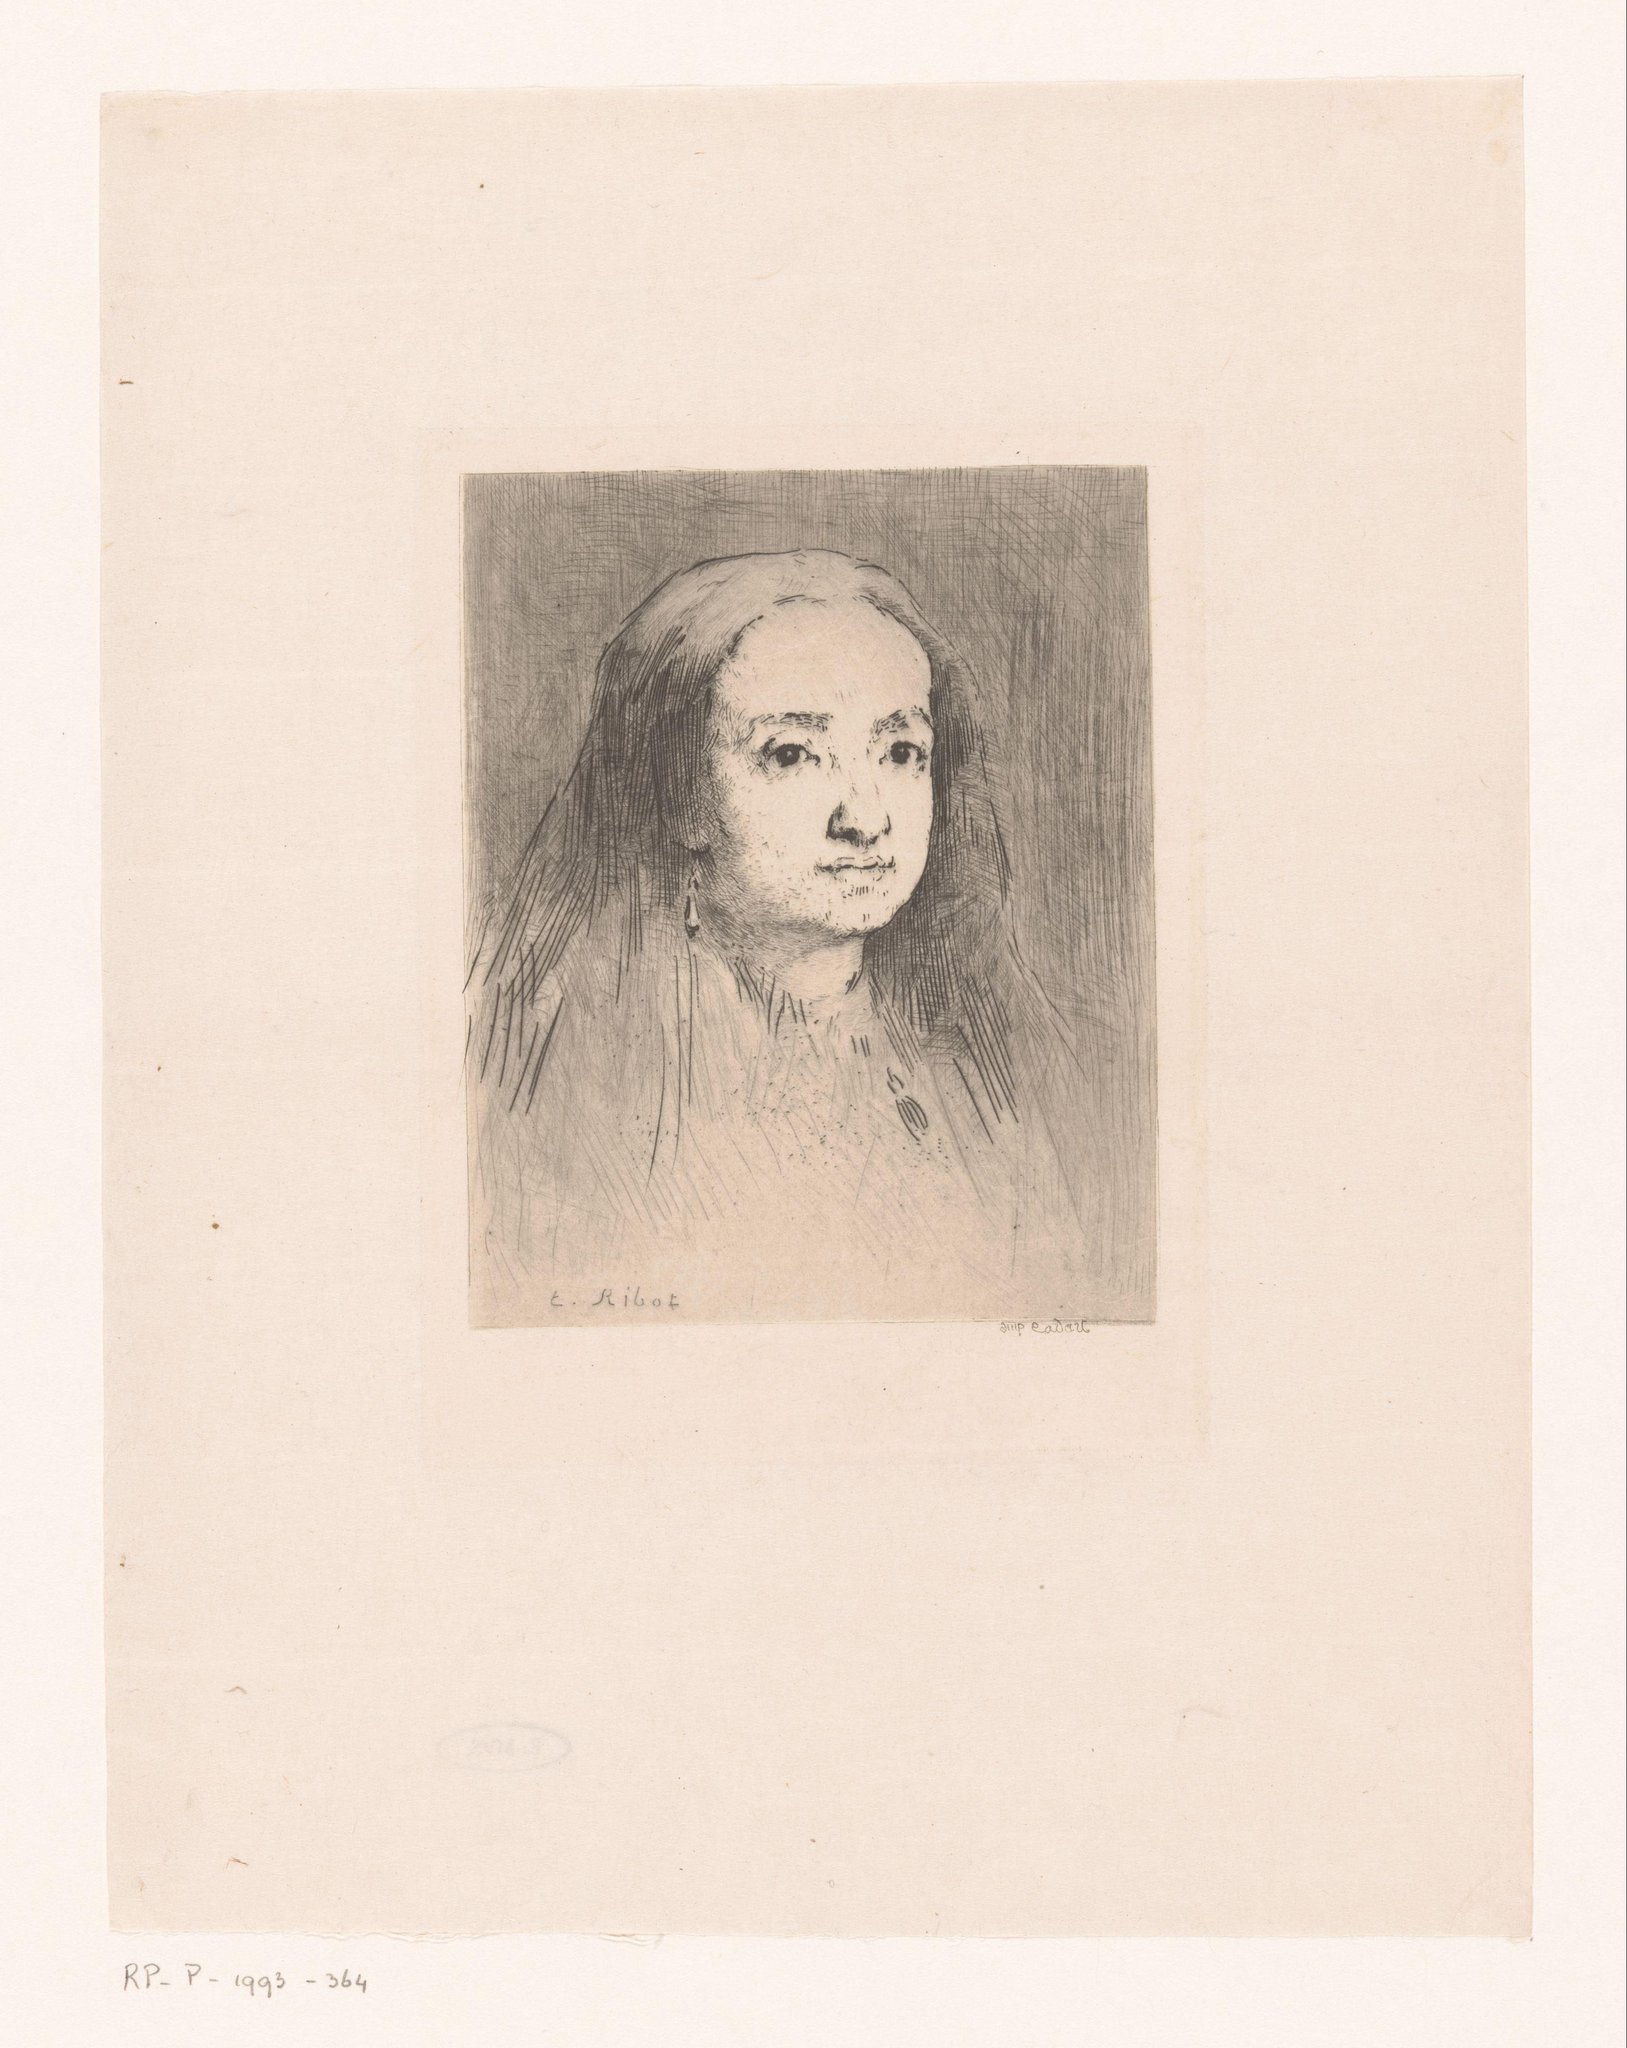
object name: print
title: Gesluierde vrouw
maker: théodule augustin ribot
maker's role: draughtsman, painter, print maker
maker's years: 1823-1891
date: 1833-1891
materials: paper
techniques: drypoint, etching, intaglio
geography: france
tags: adult woman, veil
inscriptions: collector's mark: Lugt 2228